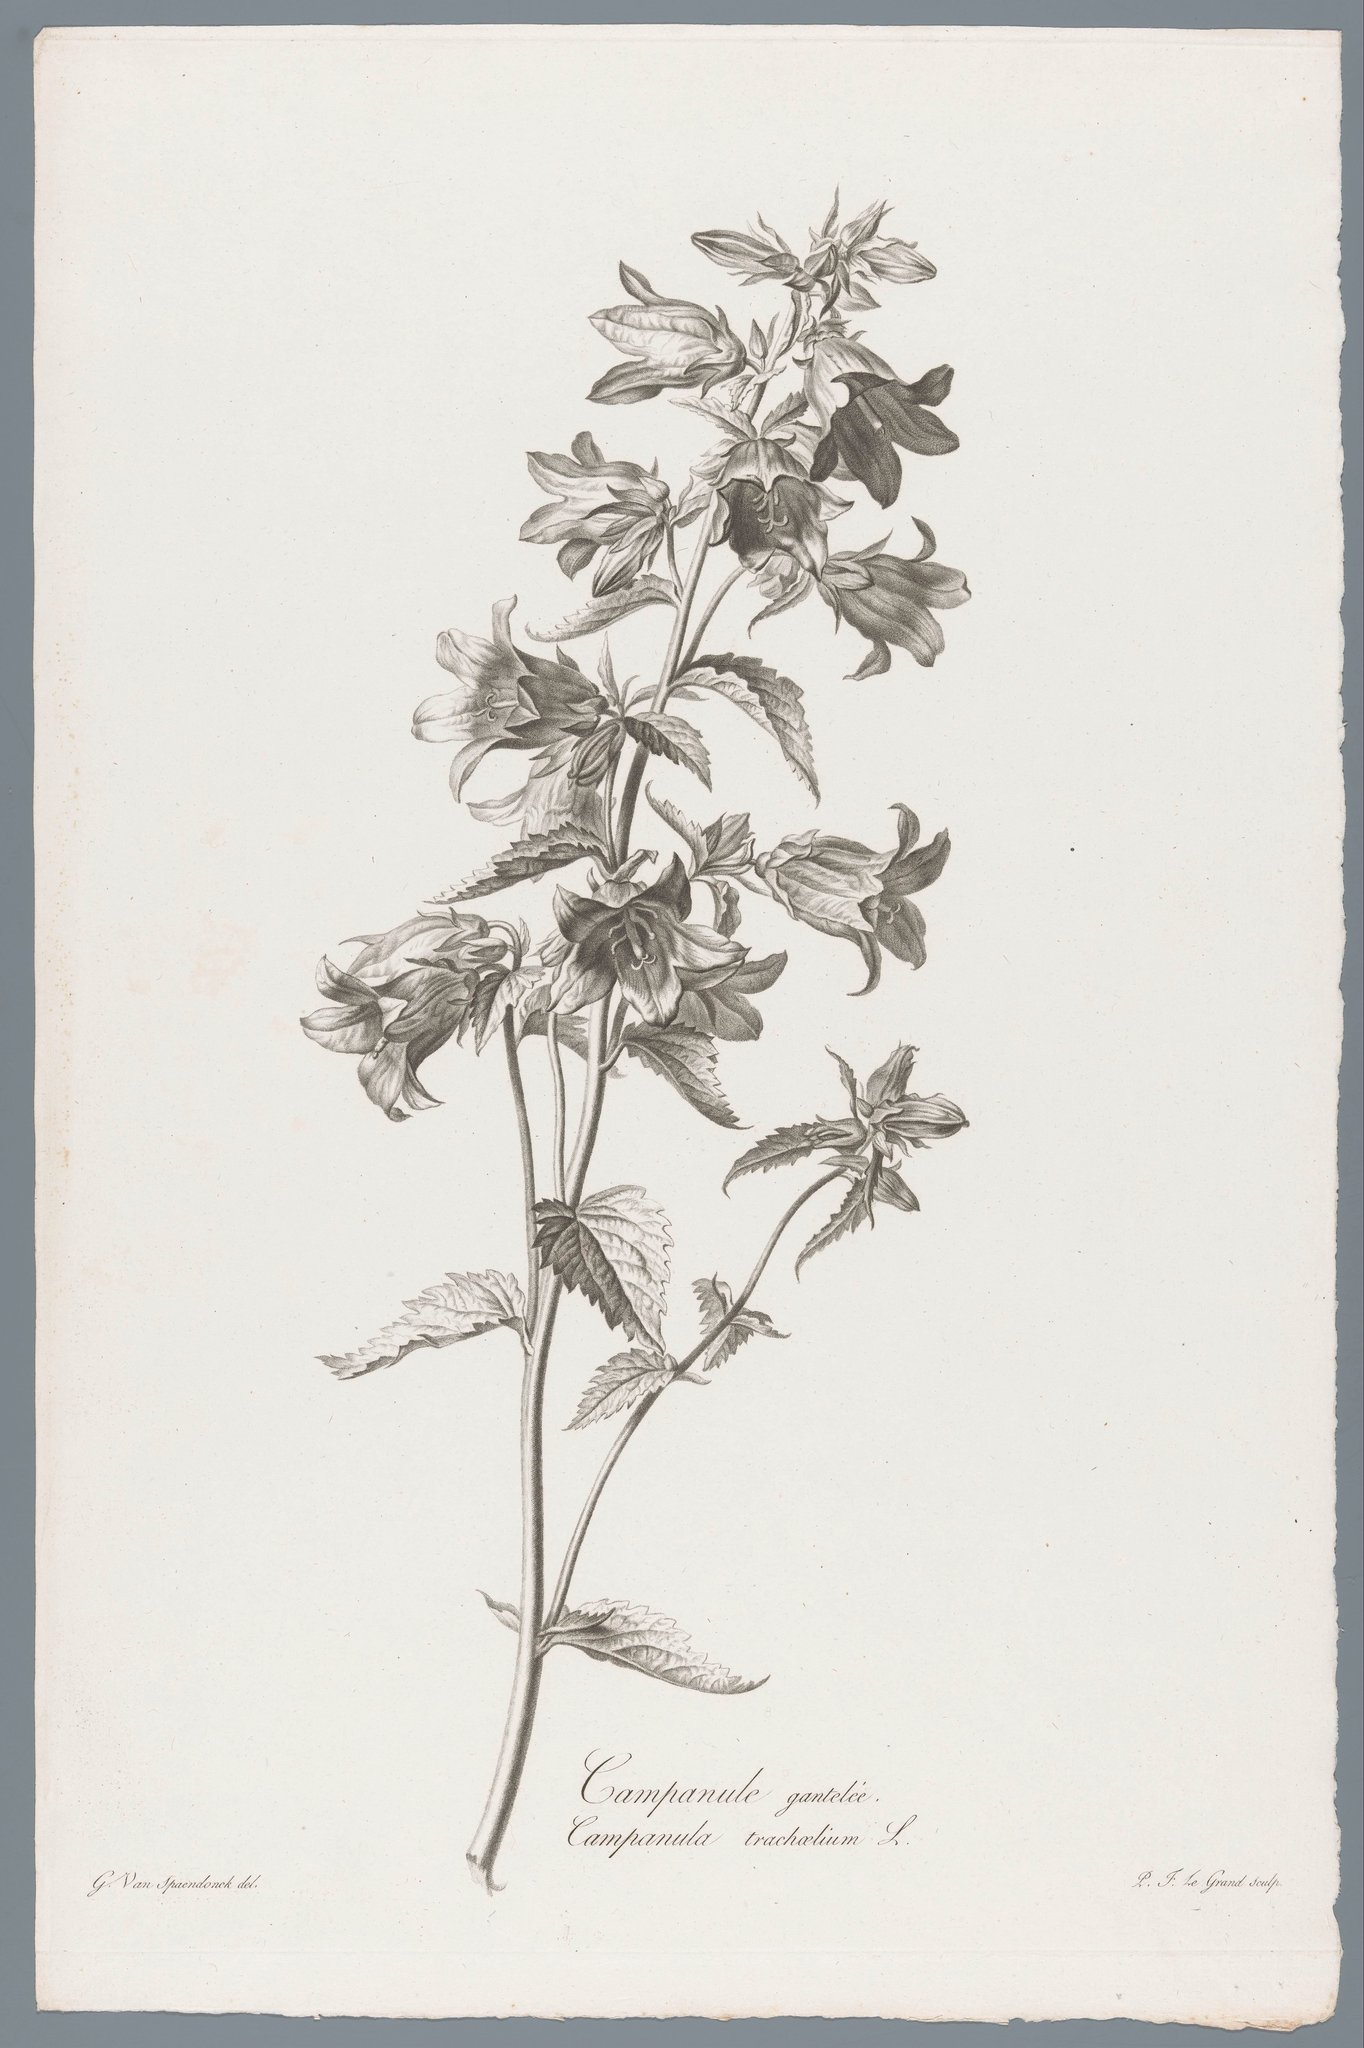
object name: print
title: Campanule gantelée / Campanula trachaelium L.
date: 1799-1801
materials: paper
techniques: engraving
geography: paris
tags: flowers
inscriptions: collector's mark: Lugt 2228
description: De serie Fleurs dessinées d'après nature (...) bestaat uit 24 prenten verdeeld over zes omslagen. Het Rijksprentenkabinet heeft 23 prenten in zes omslagen in bezit. De verdeling over de omslagen lijkt willekeurig. Zie RP-P-1909-4220 t/m 4242 en RP-P-2016-53 t/m 58.